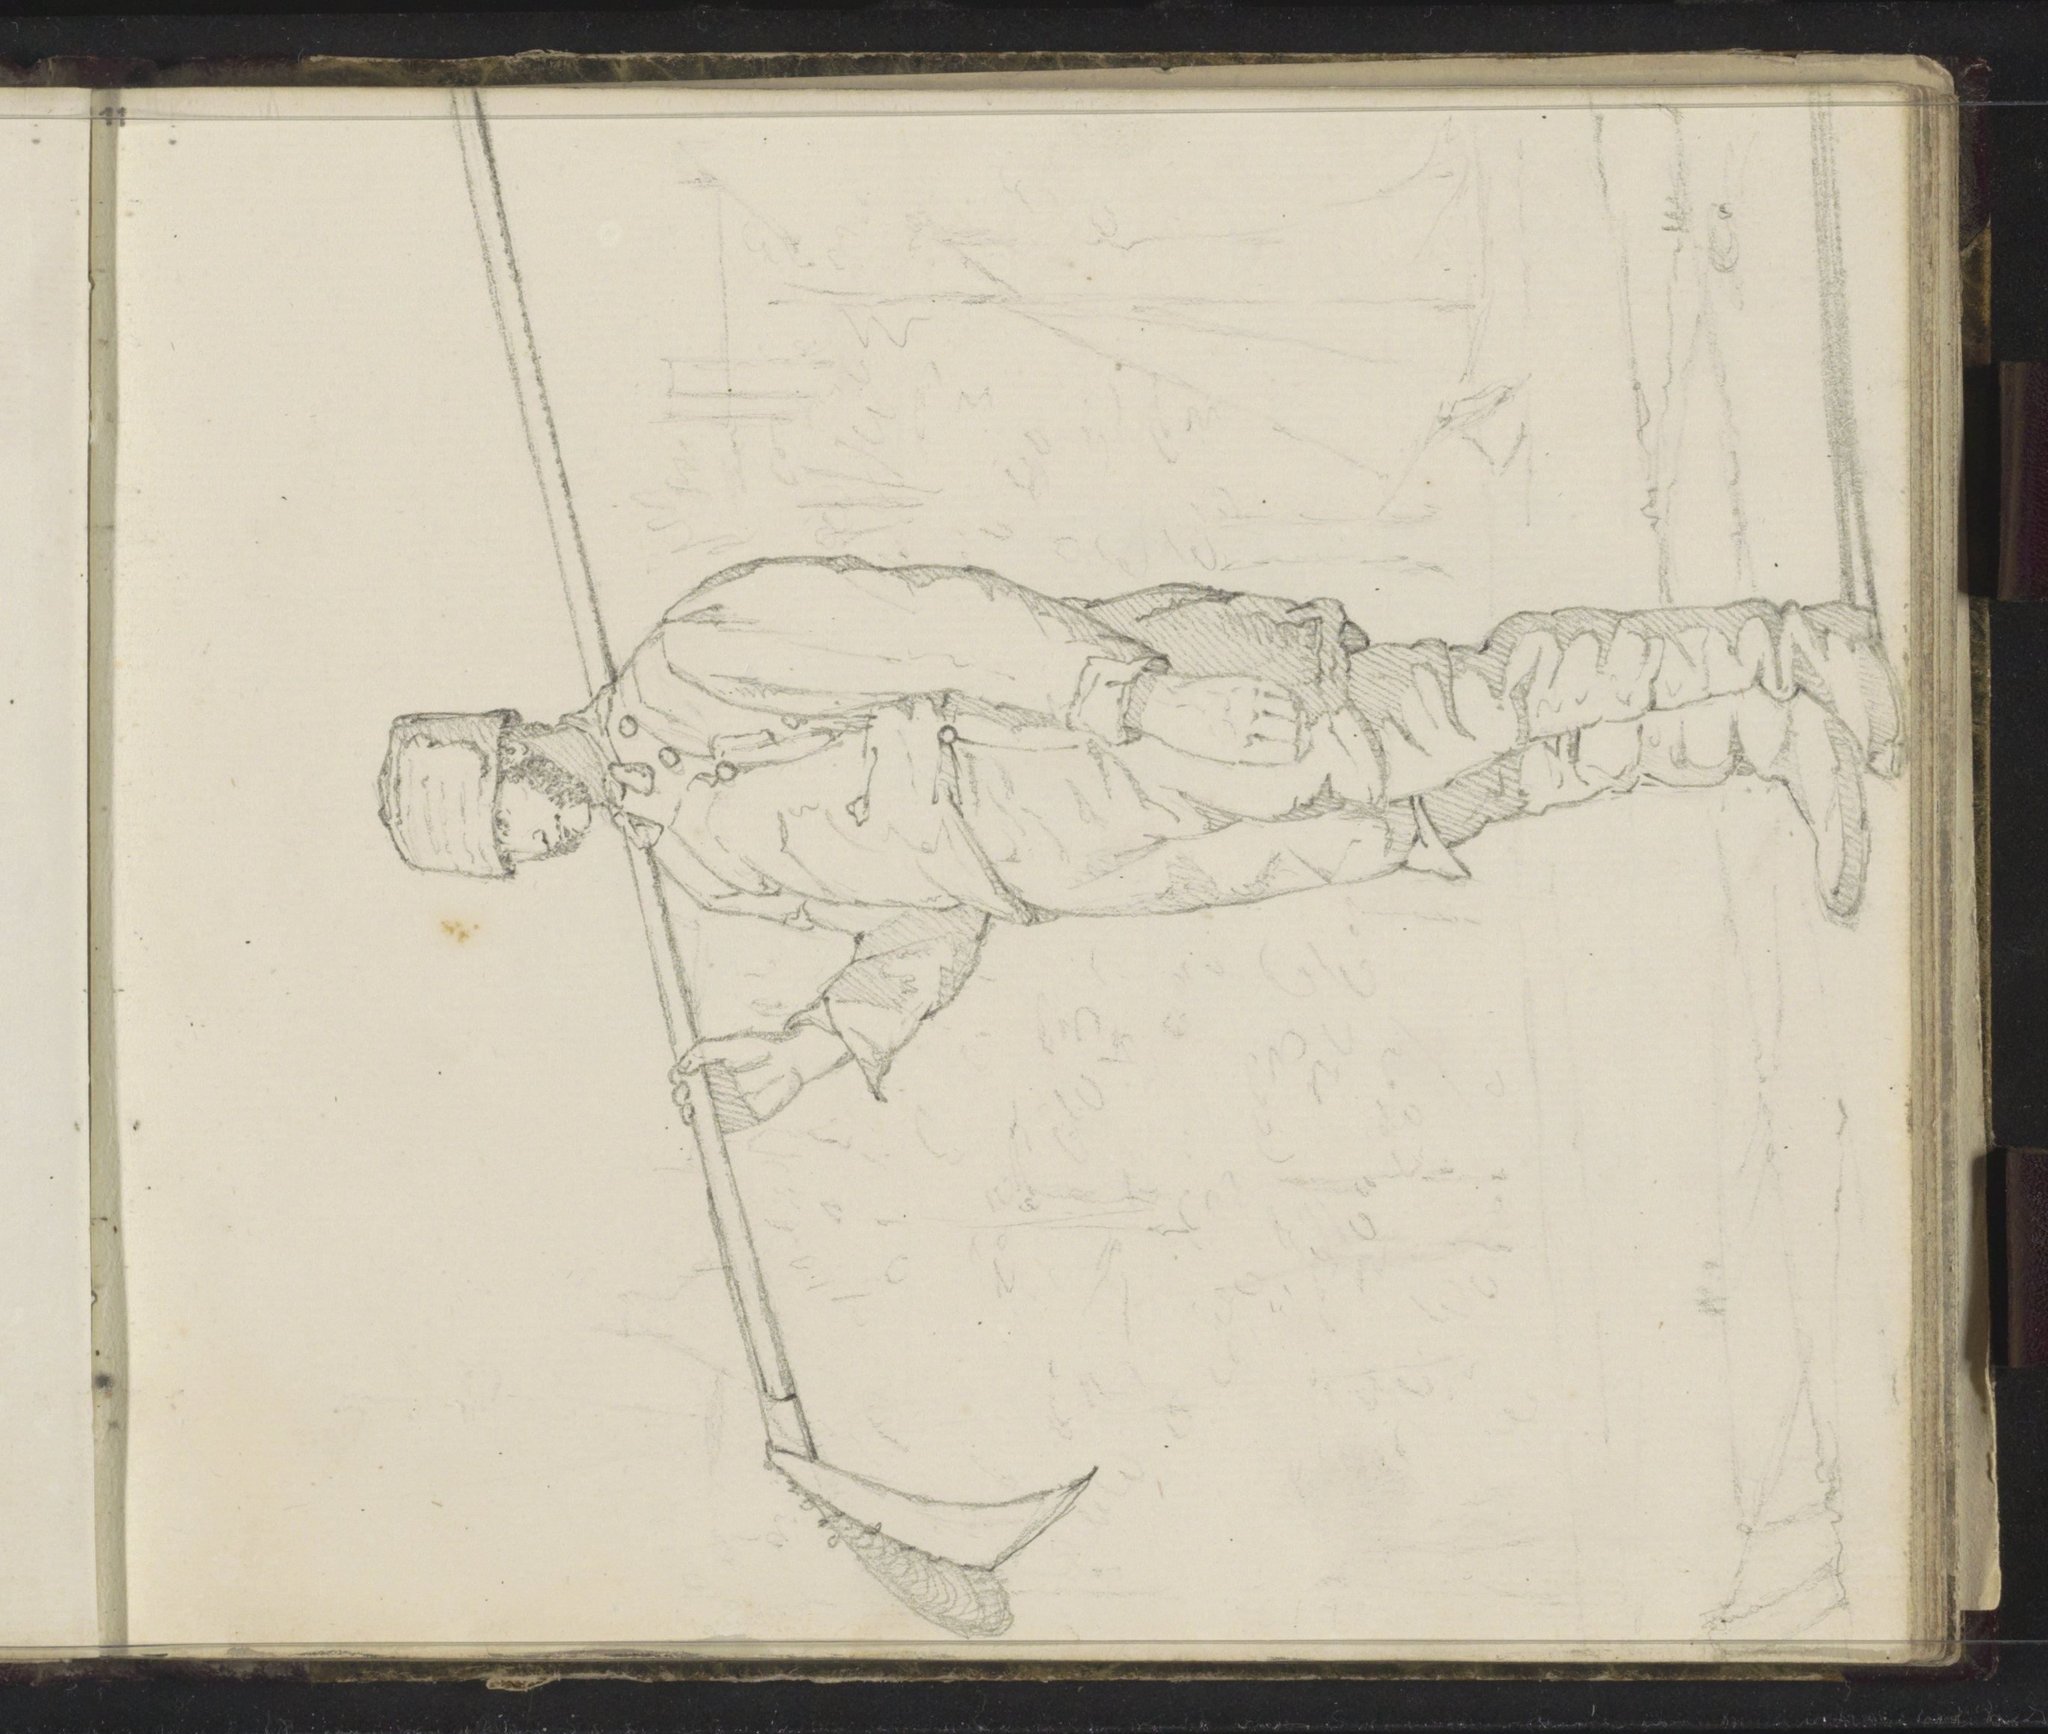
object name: sketchbook leaf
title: Man met een landbouwwerktuig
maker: hendrik abraham klinkhamer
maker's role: draughtsman, painter, print maker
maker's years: 1810-1872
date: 1820-1872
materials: paper, pencil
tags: agricultural implements (+ labourers ~ crafts, industries, agriculture)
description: De man draagt hoge laarzen en heeft mogelijk een zeis op de rechterschouder. Blad 11 recto uit een schetsboek met 39 bladen.